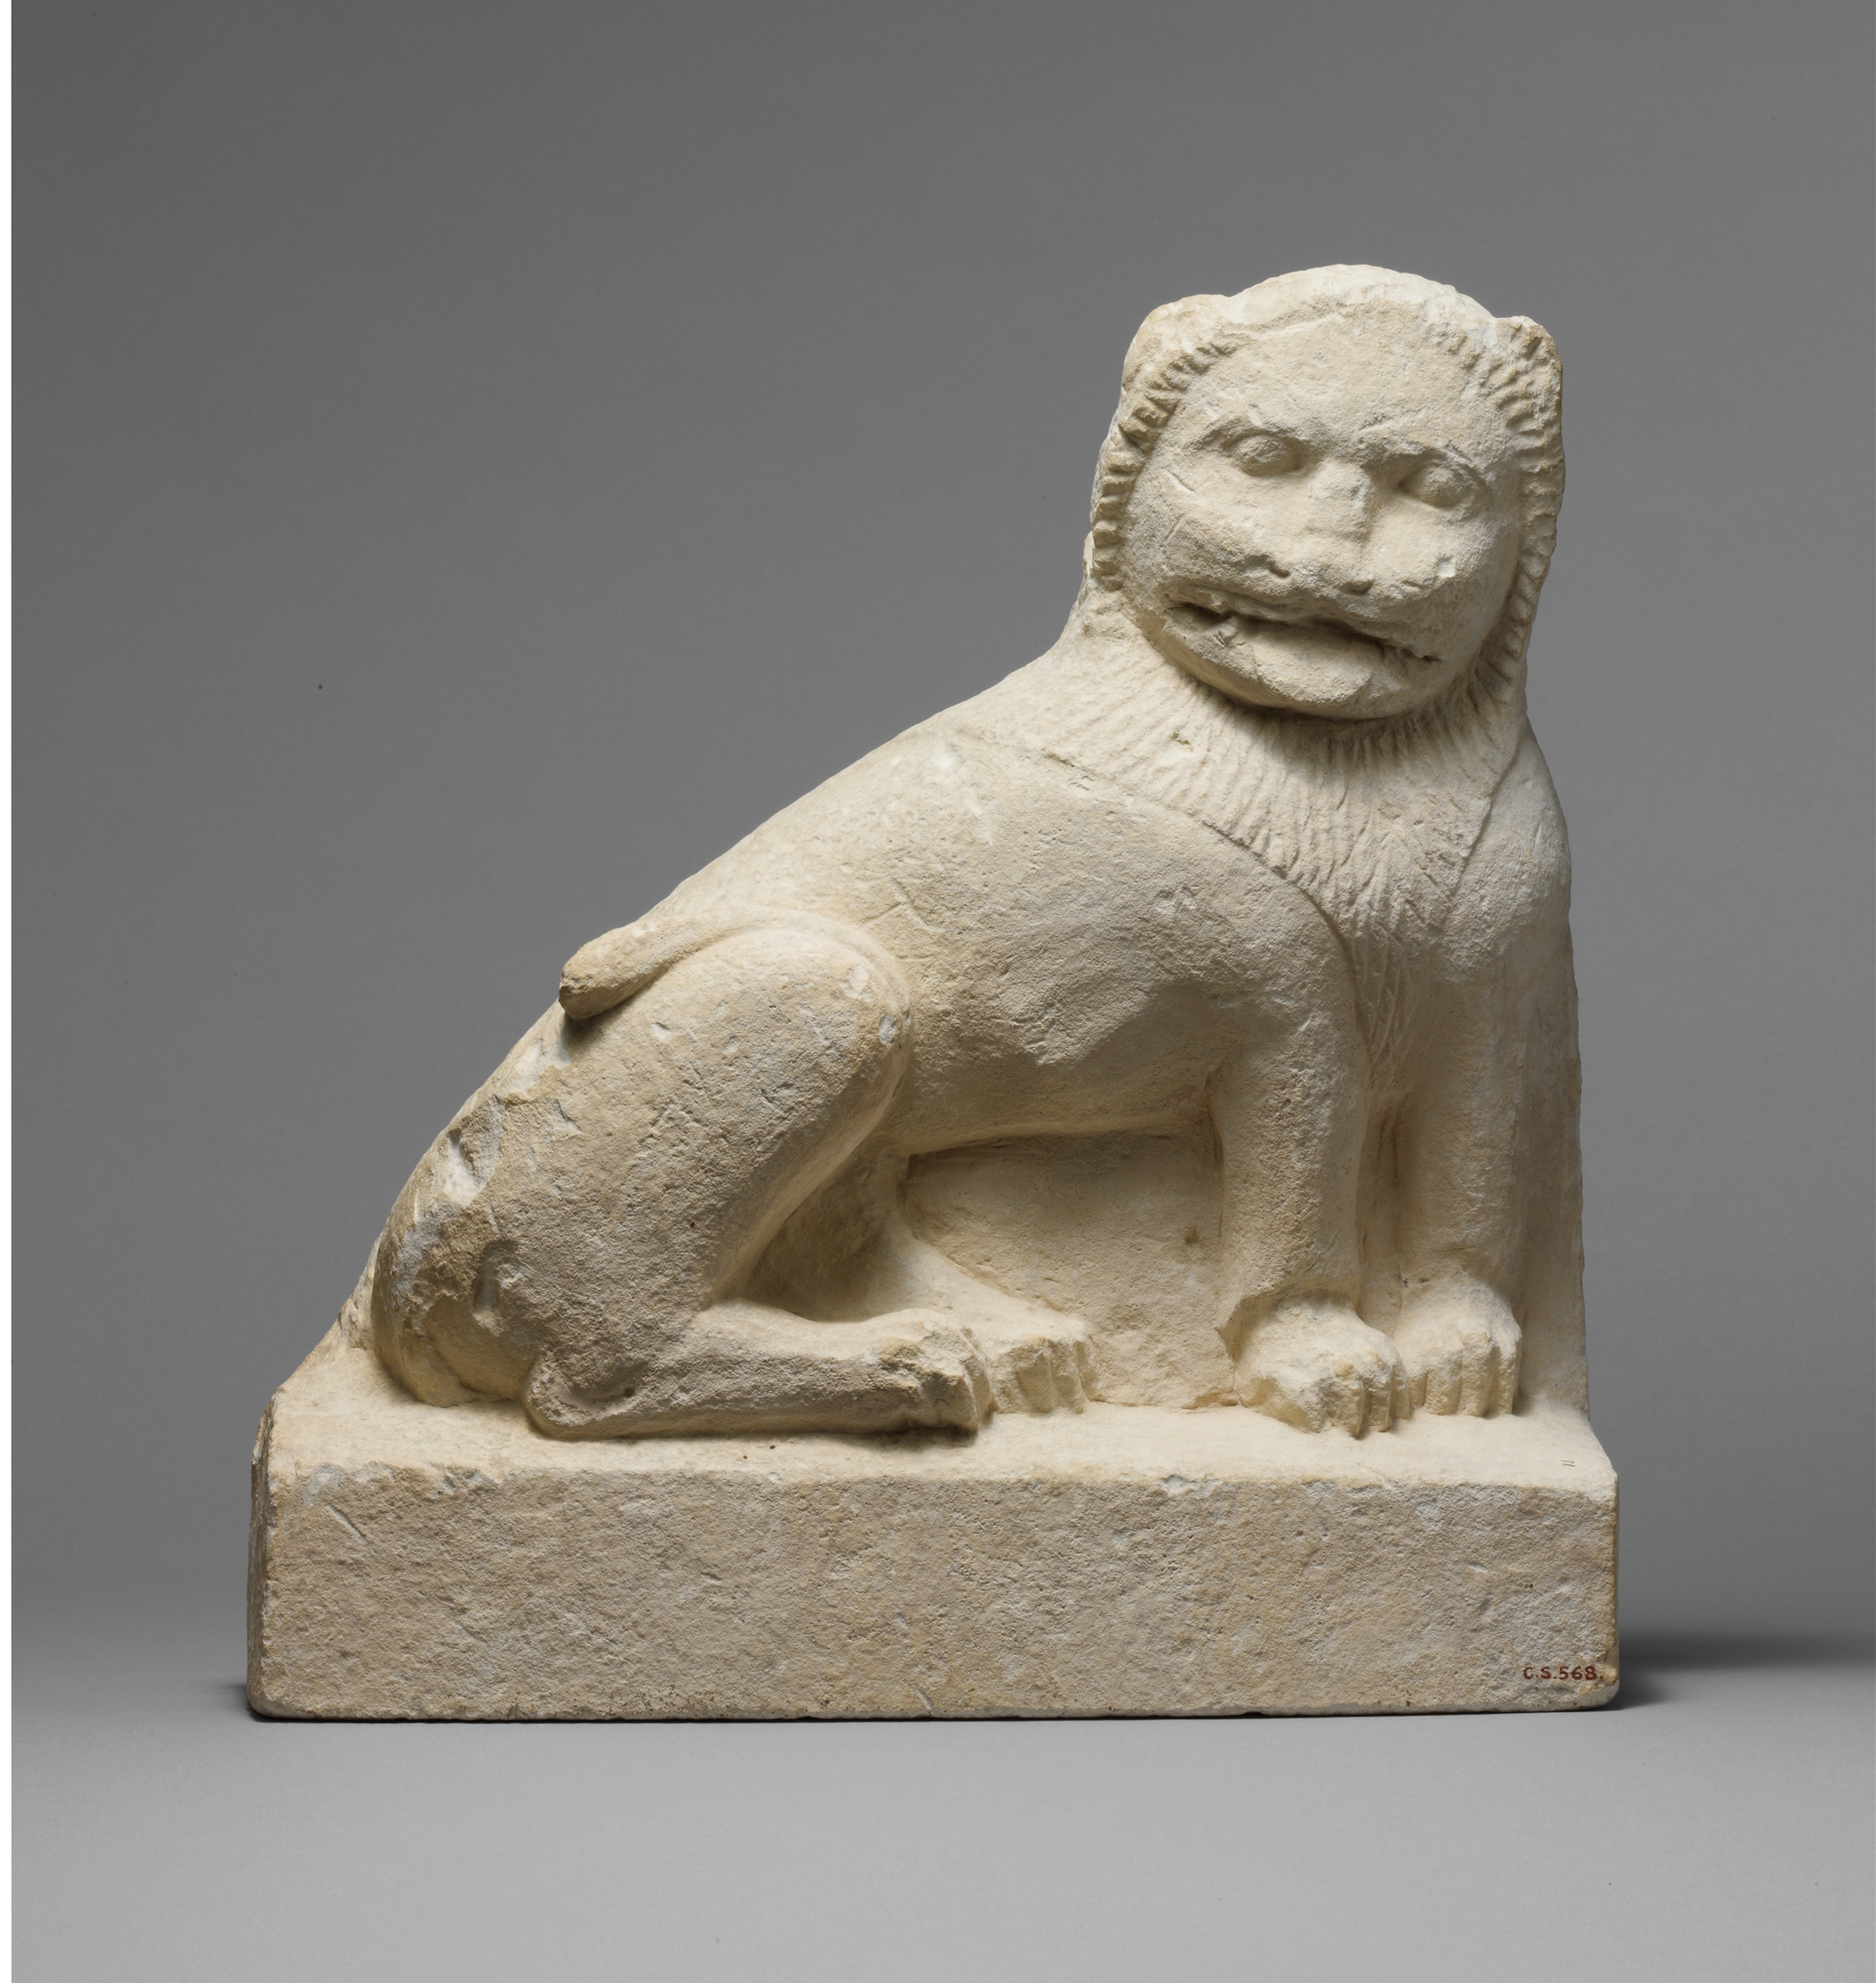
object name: statuette of a lion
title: Limestone statue of a seated lion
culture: cypriot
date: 400-301 BCE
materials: limestone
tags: lions